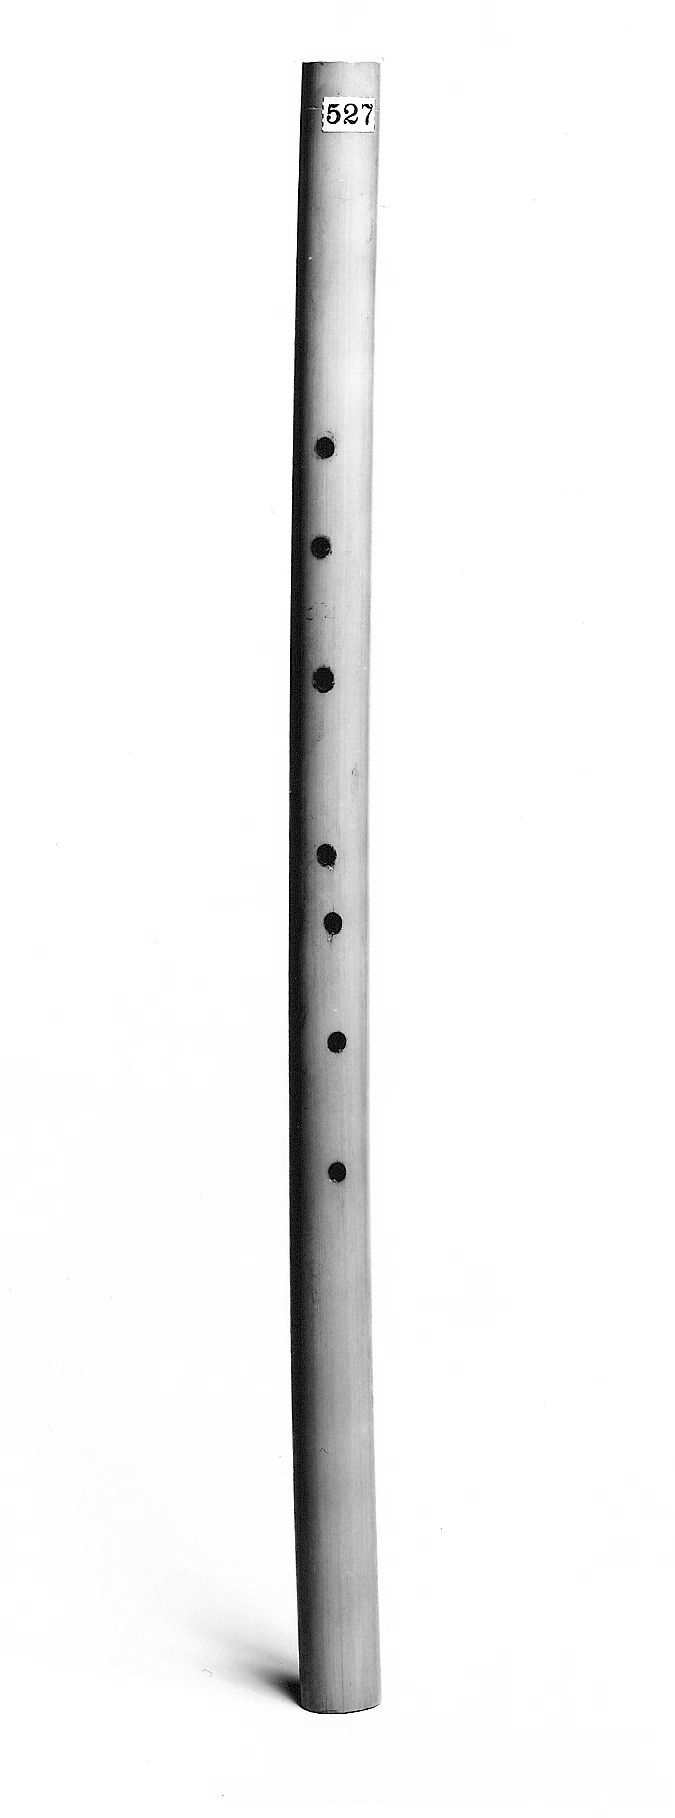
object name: flute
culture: malagasy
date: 1867-1900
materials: bamboo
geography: madagascar